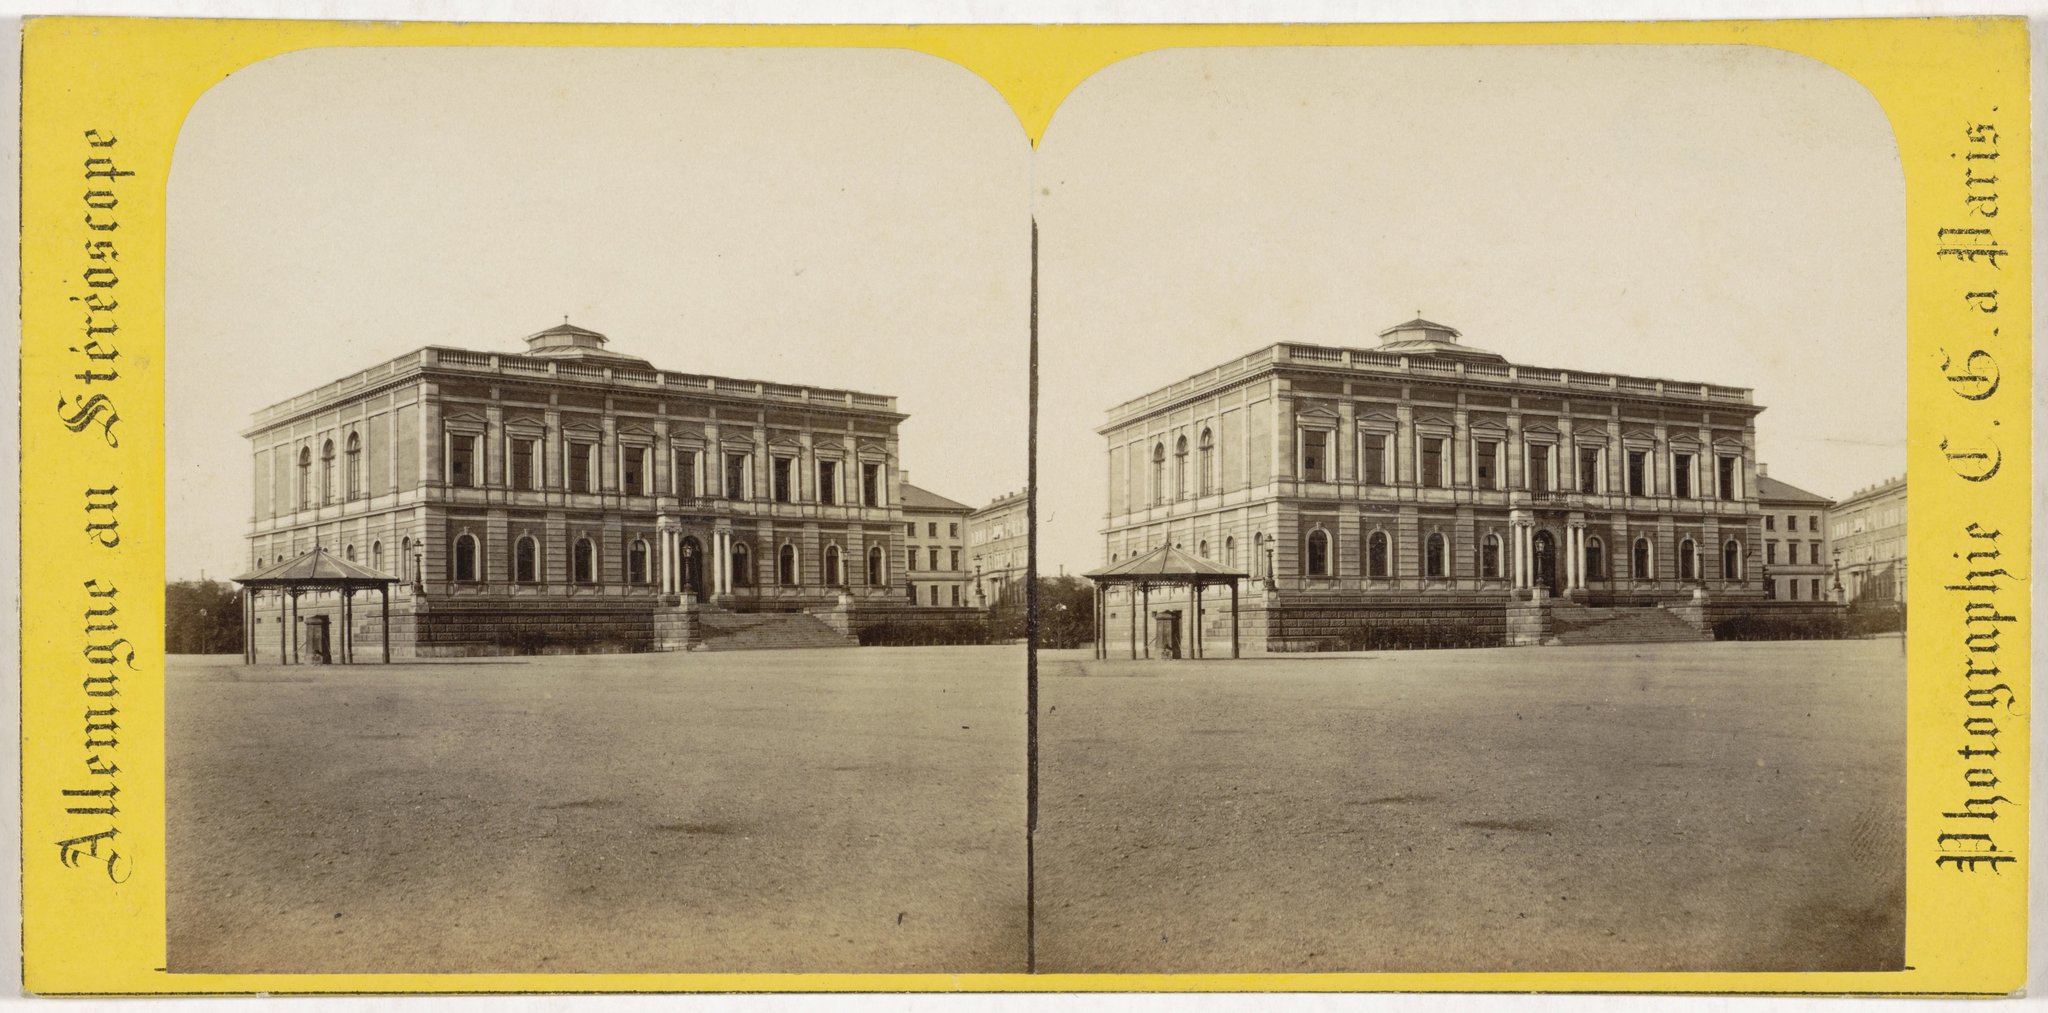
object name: stereograph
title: Leipzig (Saxe), le museum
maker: charles gaudin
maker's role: publisher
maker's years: 1825-1905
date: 1860-1870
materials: cardboard, paper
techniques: albumen print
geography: leipzig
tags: exterior ~ representation of a building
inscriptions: inscription: ‘60’, number: ‘247.’, number: ‘247’